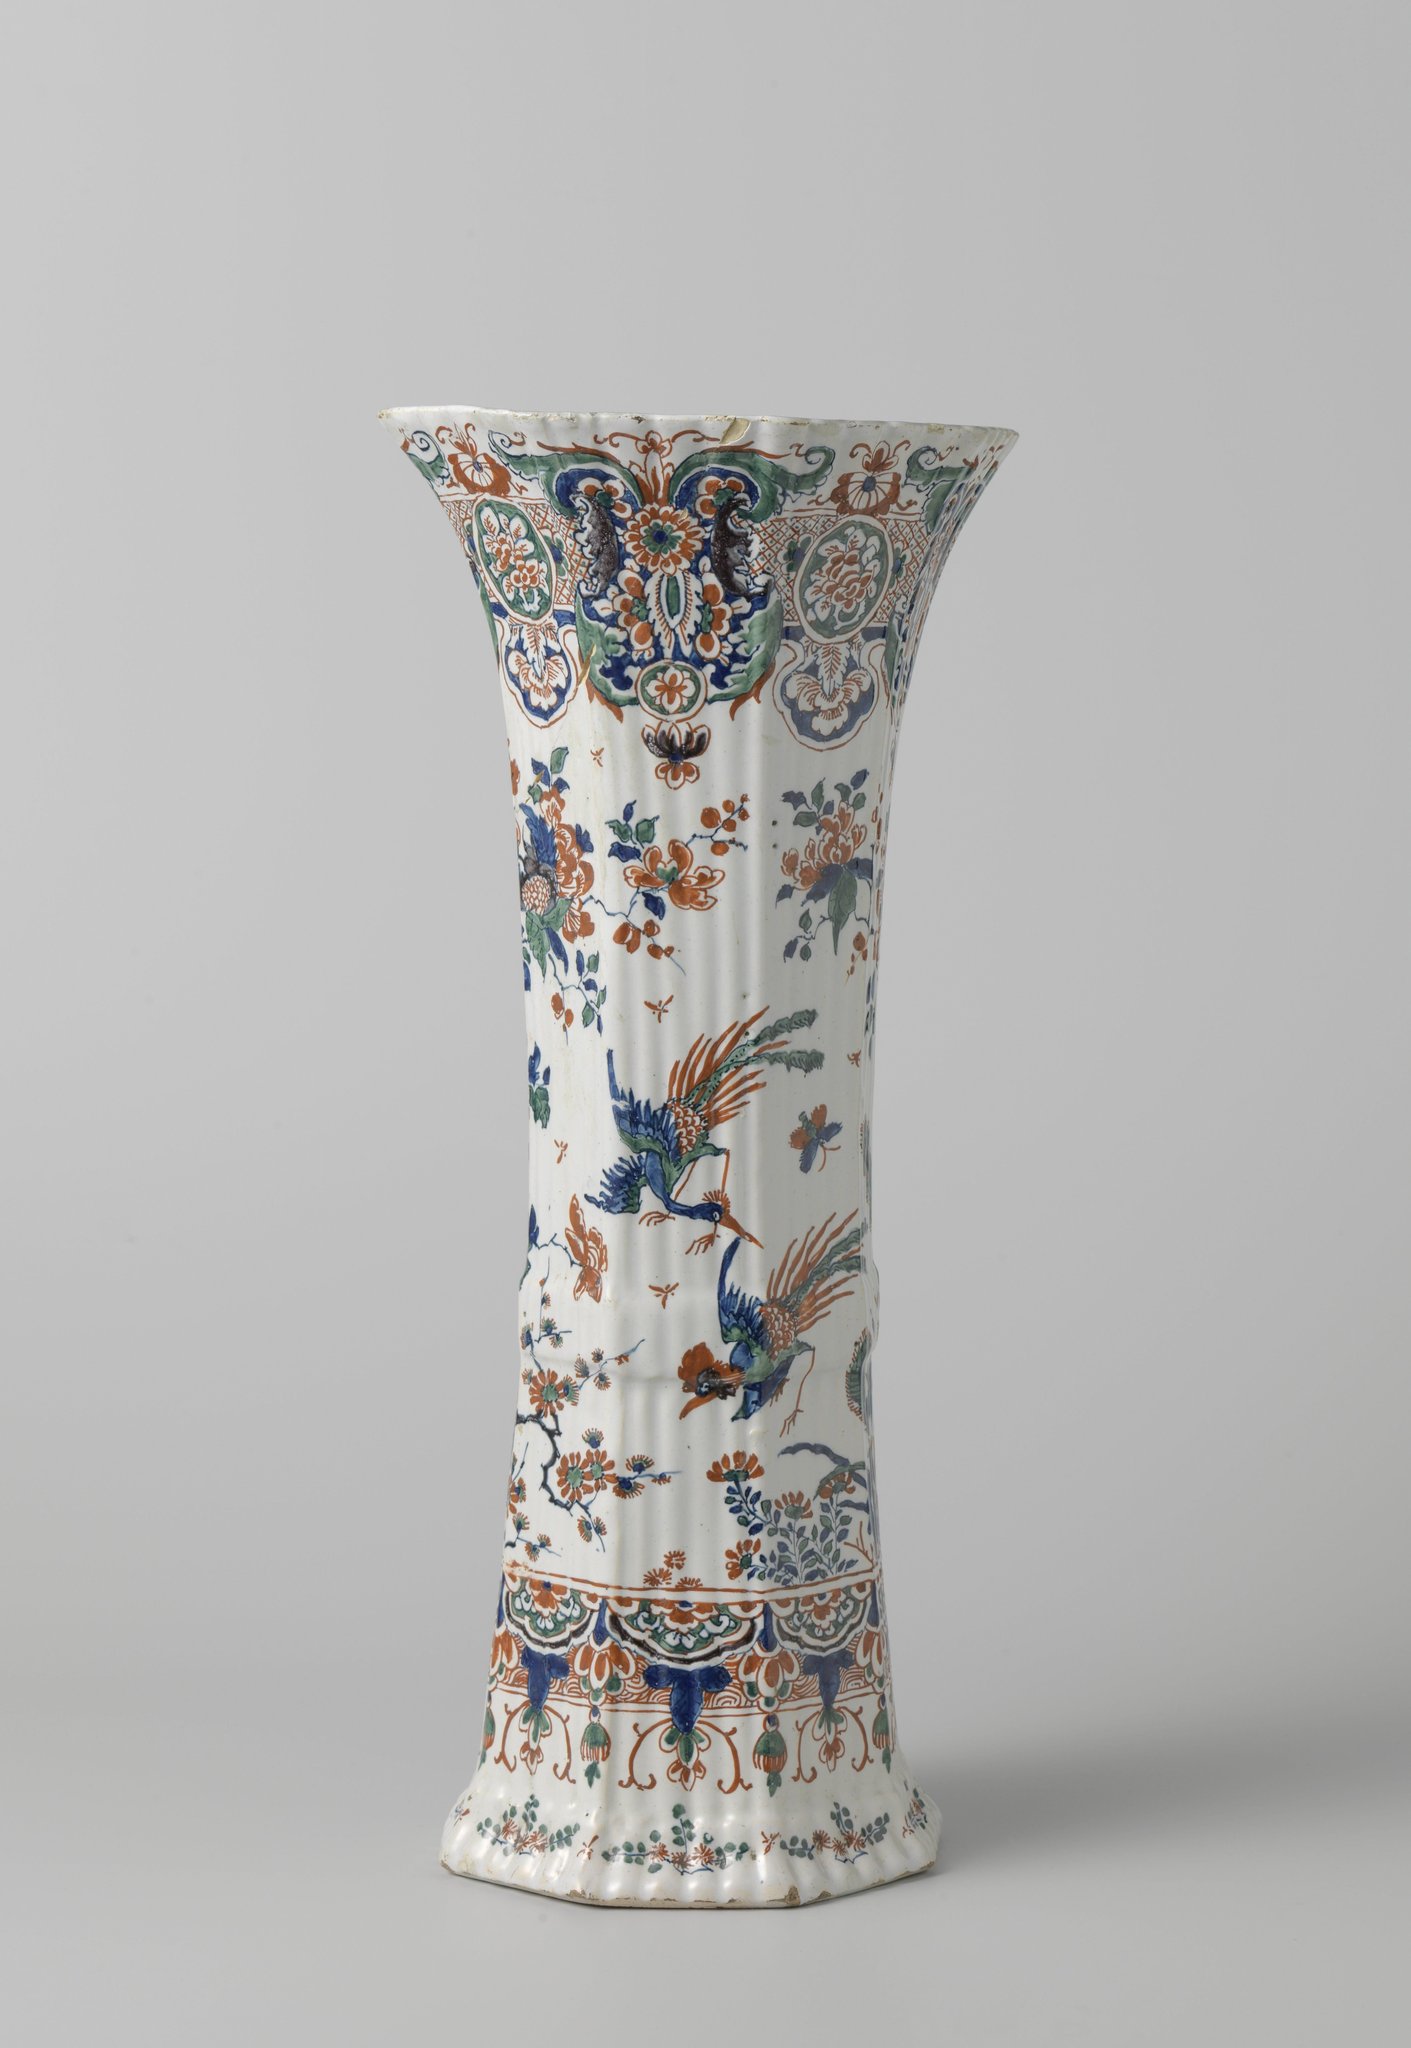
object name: kaststel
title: Achtkantige geribde pot van veelkleurige faïence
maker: lambertus van eenhoorn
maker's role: plateelbakker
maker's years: 1651-1721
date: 1695-1725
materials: earthenware, glaze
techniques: painted, polychromy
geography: delft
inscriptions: mark: ‘LVE (ineen)/ IVK/ 3/ 0’, collector's mark: ‘collection J.F. Loudon’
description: Cabinet set. Faience. Delft, 'De Dobbelde Schenckan', under Louwijs Fictoor, c. 1700. Presented by the heirs of John F. Loudon, 1916.